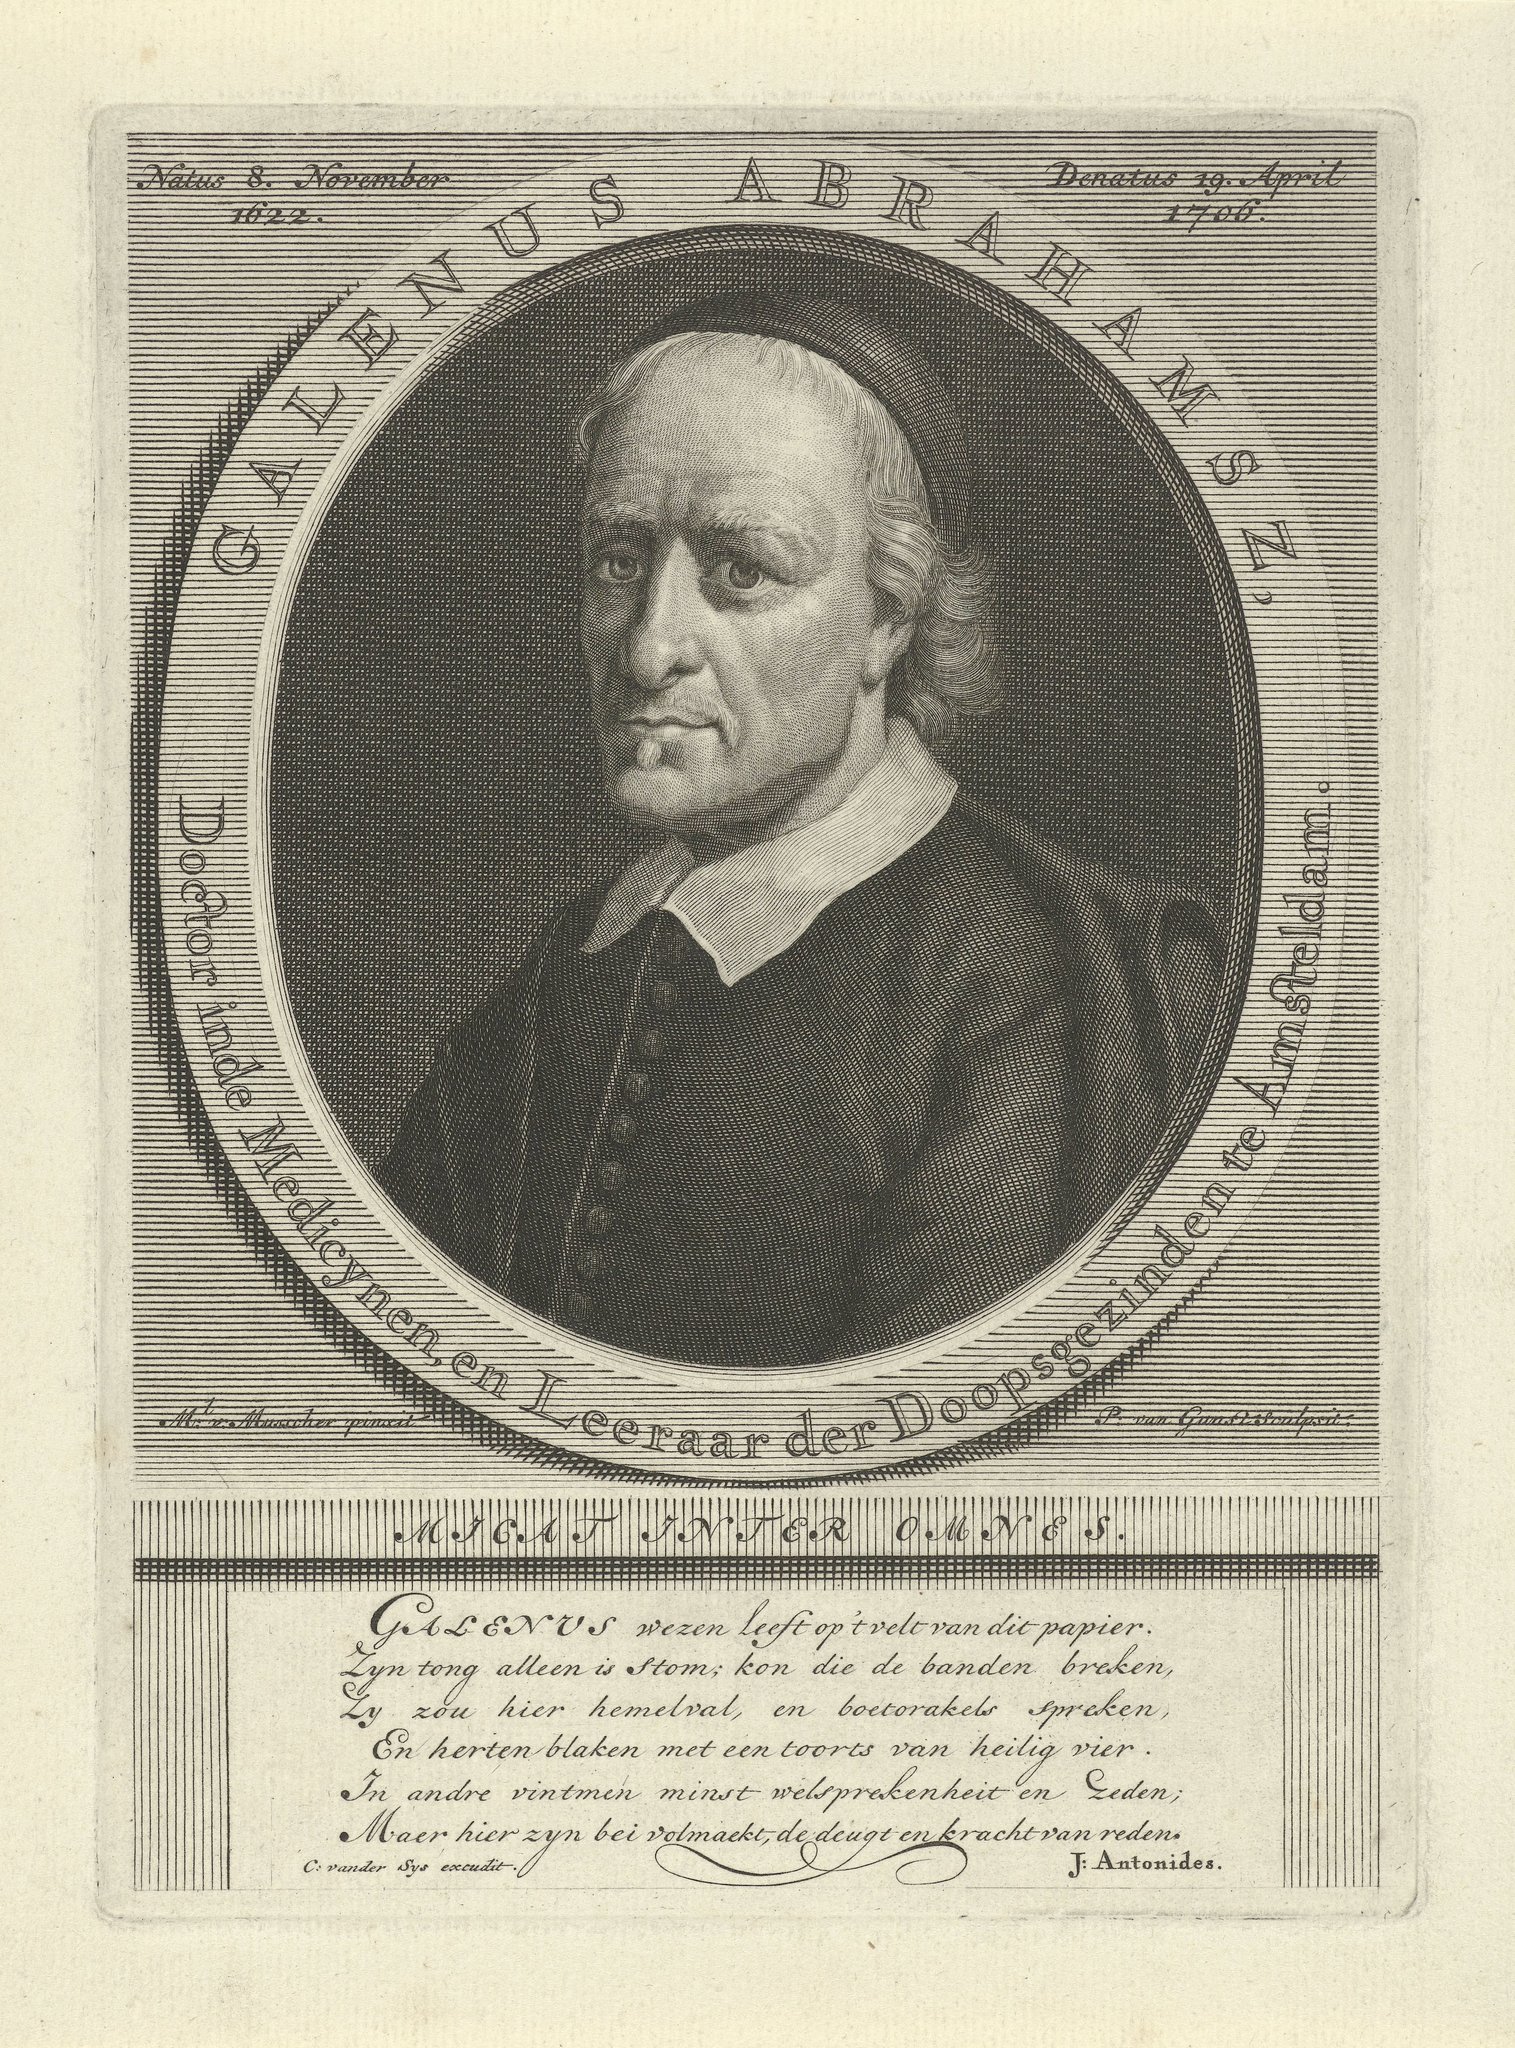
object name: print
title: Portret van Galenus Abrahamsz. de Haan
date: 1706-1731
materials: paper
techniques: engraving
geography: amsterdam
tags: galenus abrahamsz. de haan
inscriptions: collector's mark: Lugt 2228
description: Galenus Abrahamsz. de Haan, doopsgezinde predikant en geneesheer te Amsterdam. De prent heeft als onderschrift een Nederlands gedicht over zijn leven.